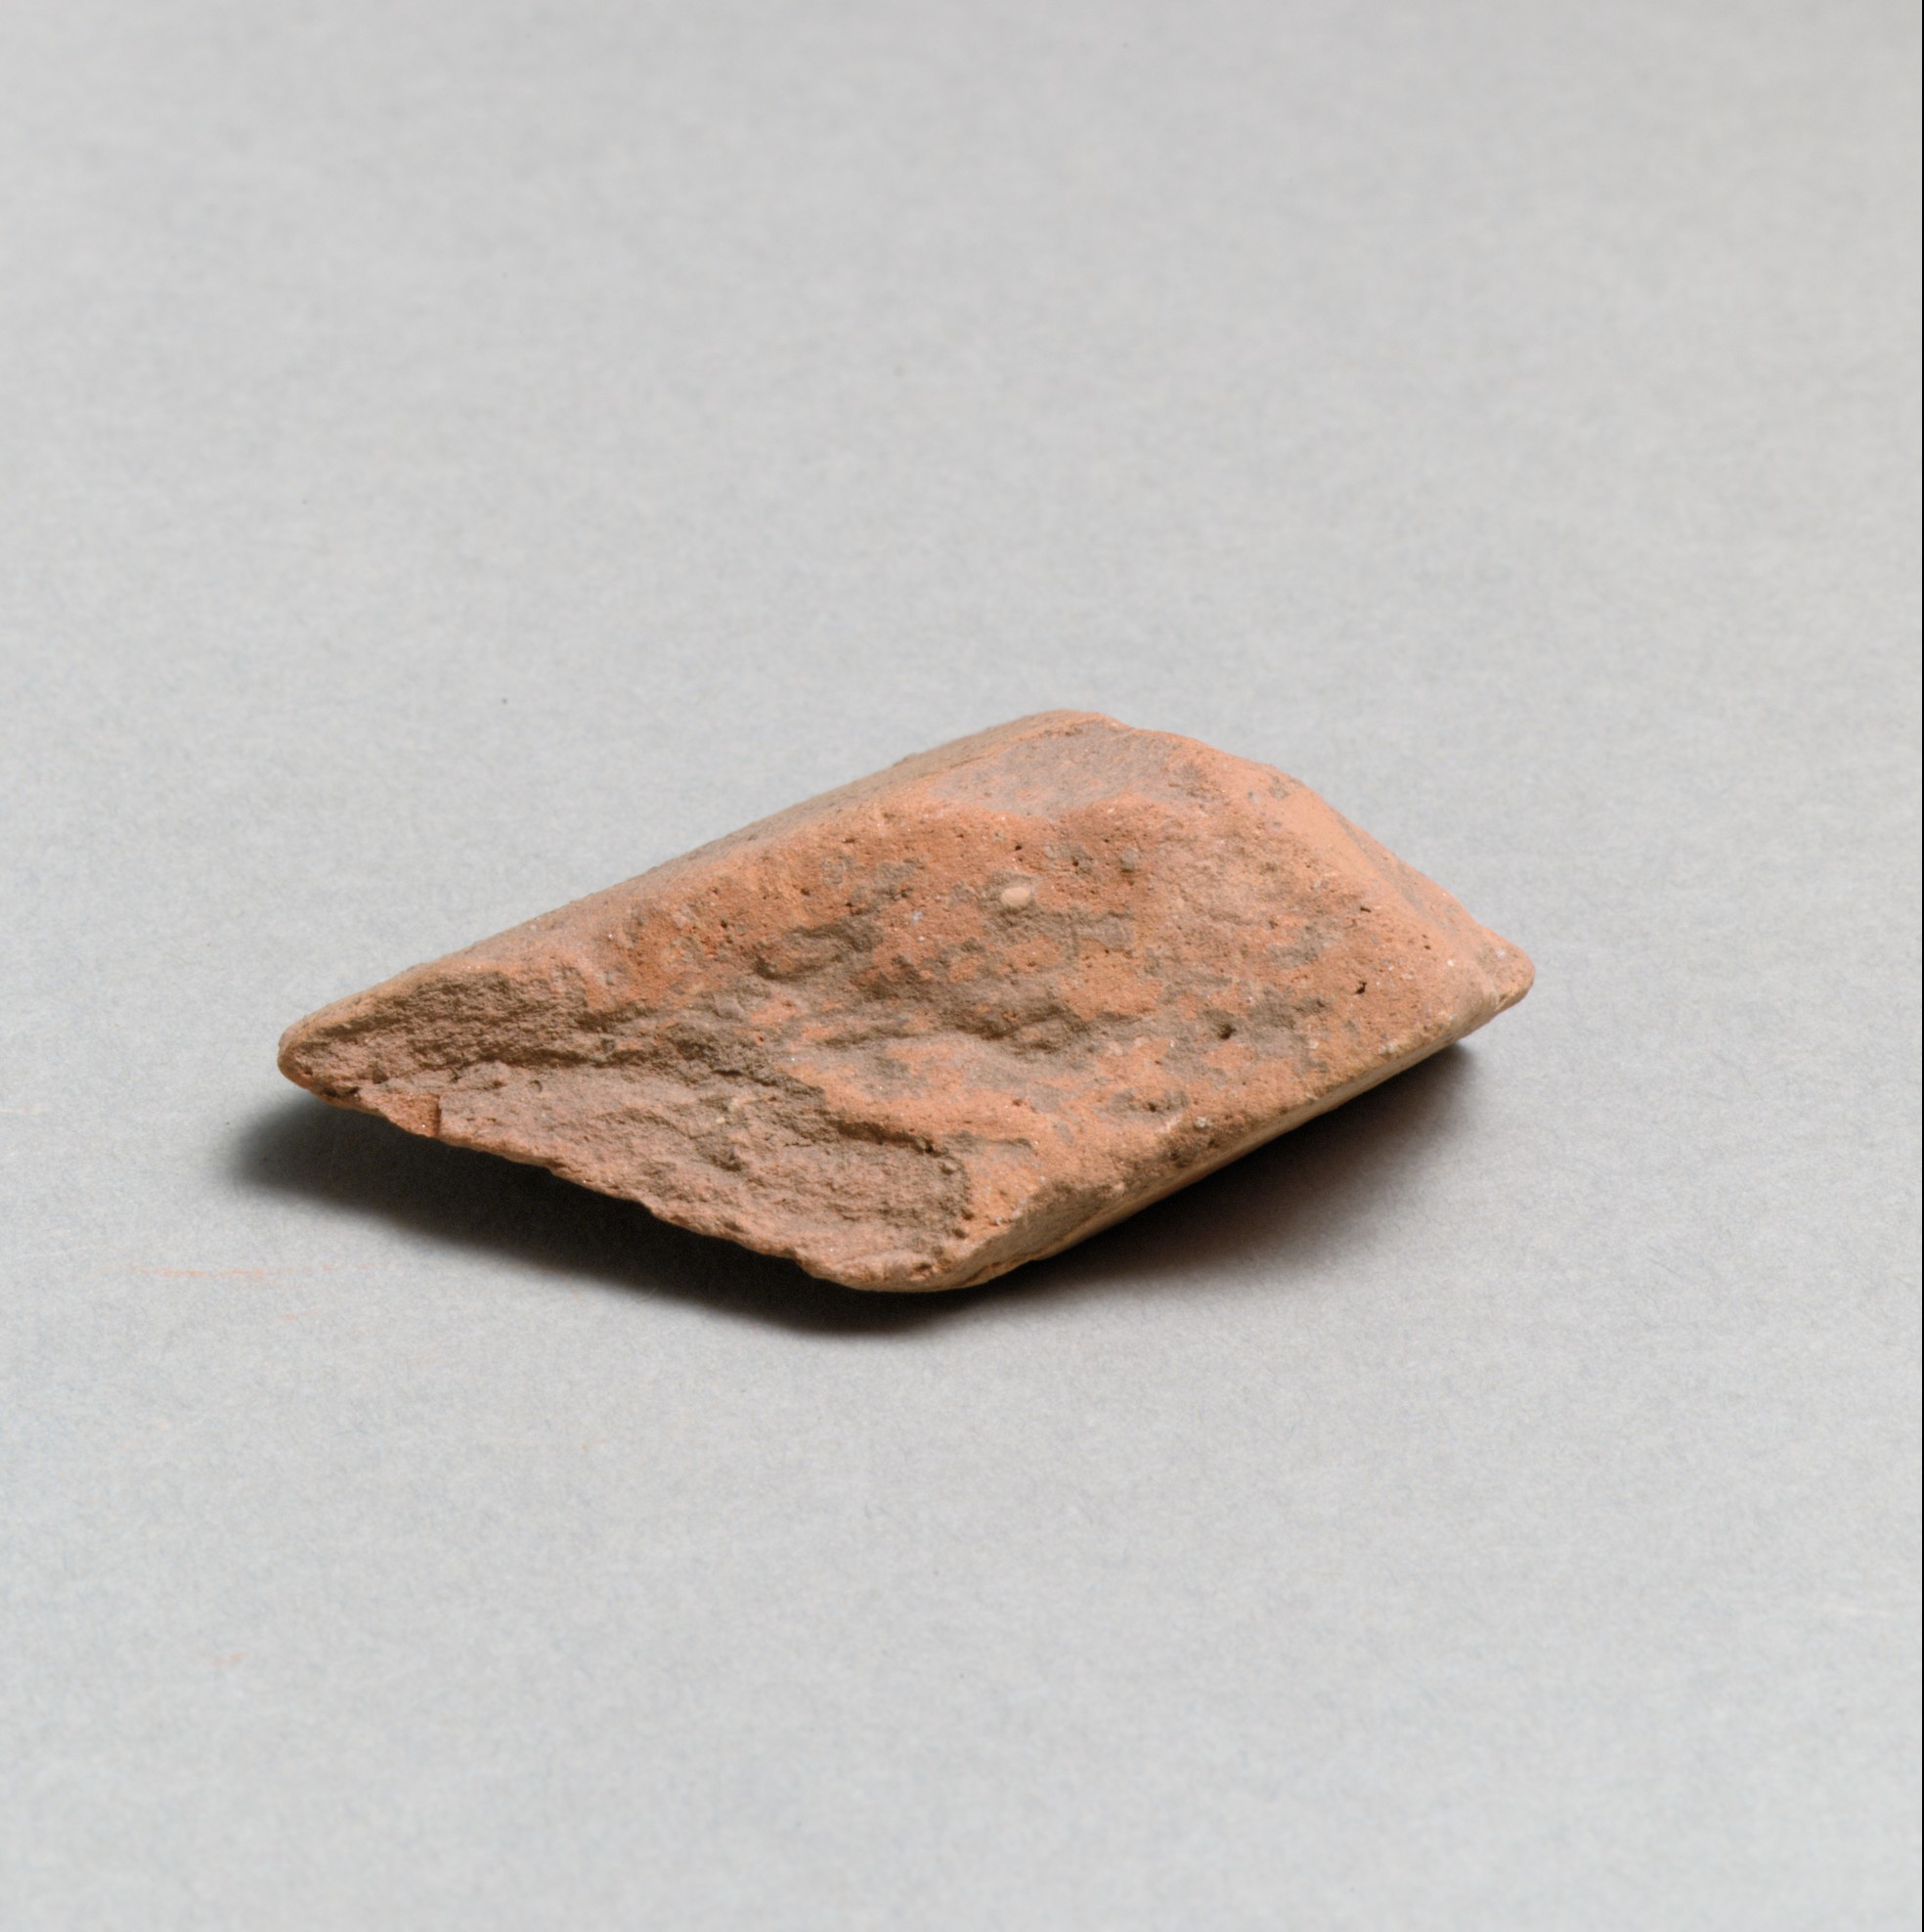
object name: vase fragment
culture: greek or lydian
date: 900-30 BCE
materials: terracotta